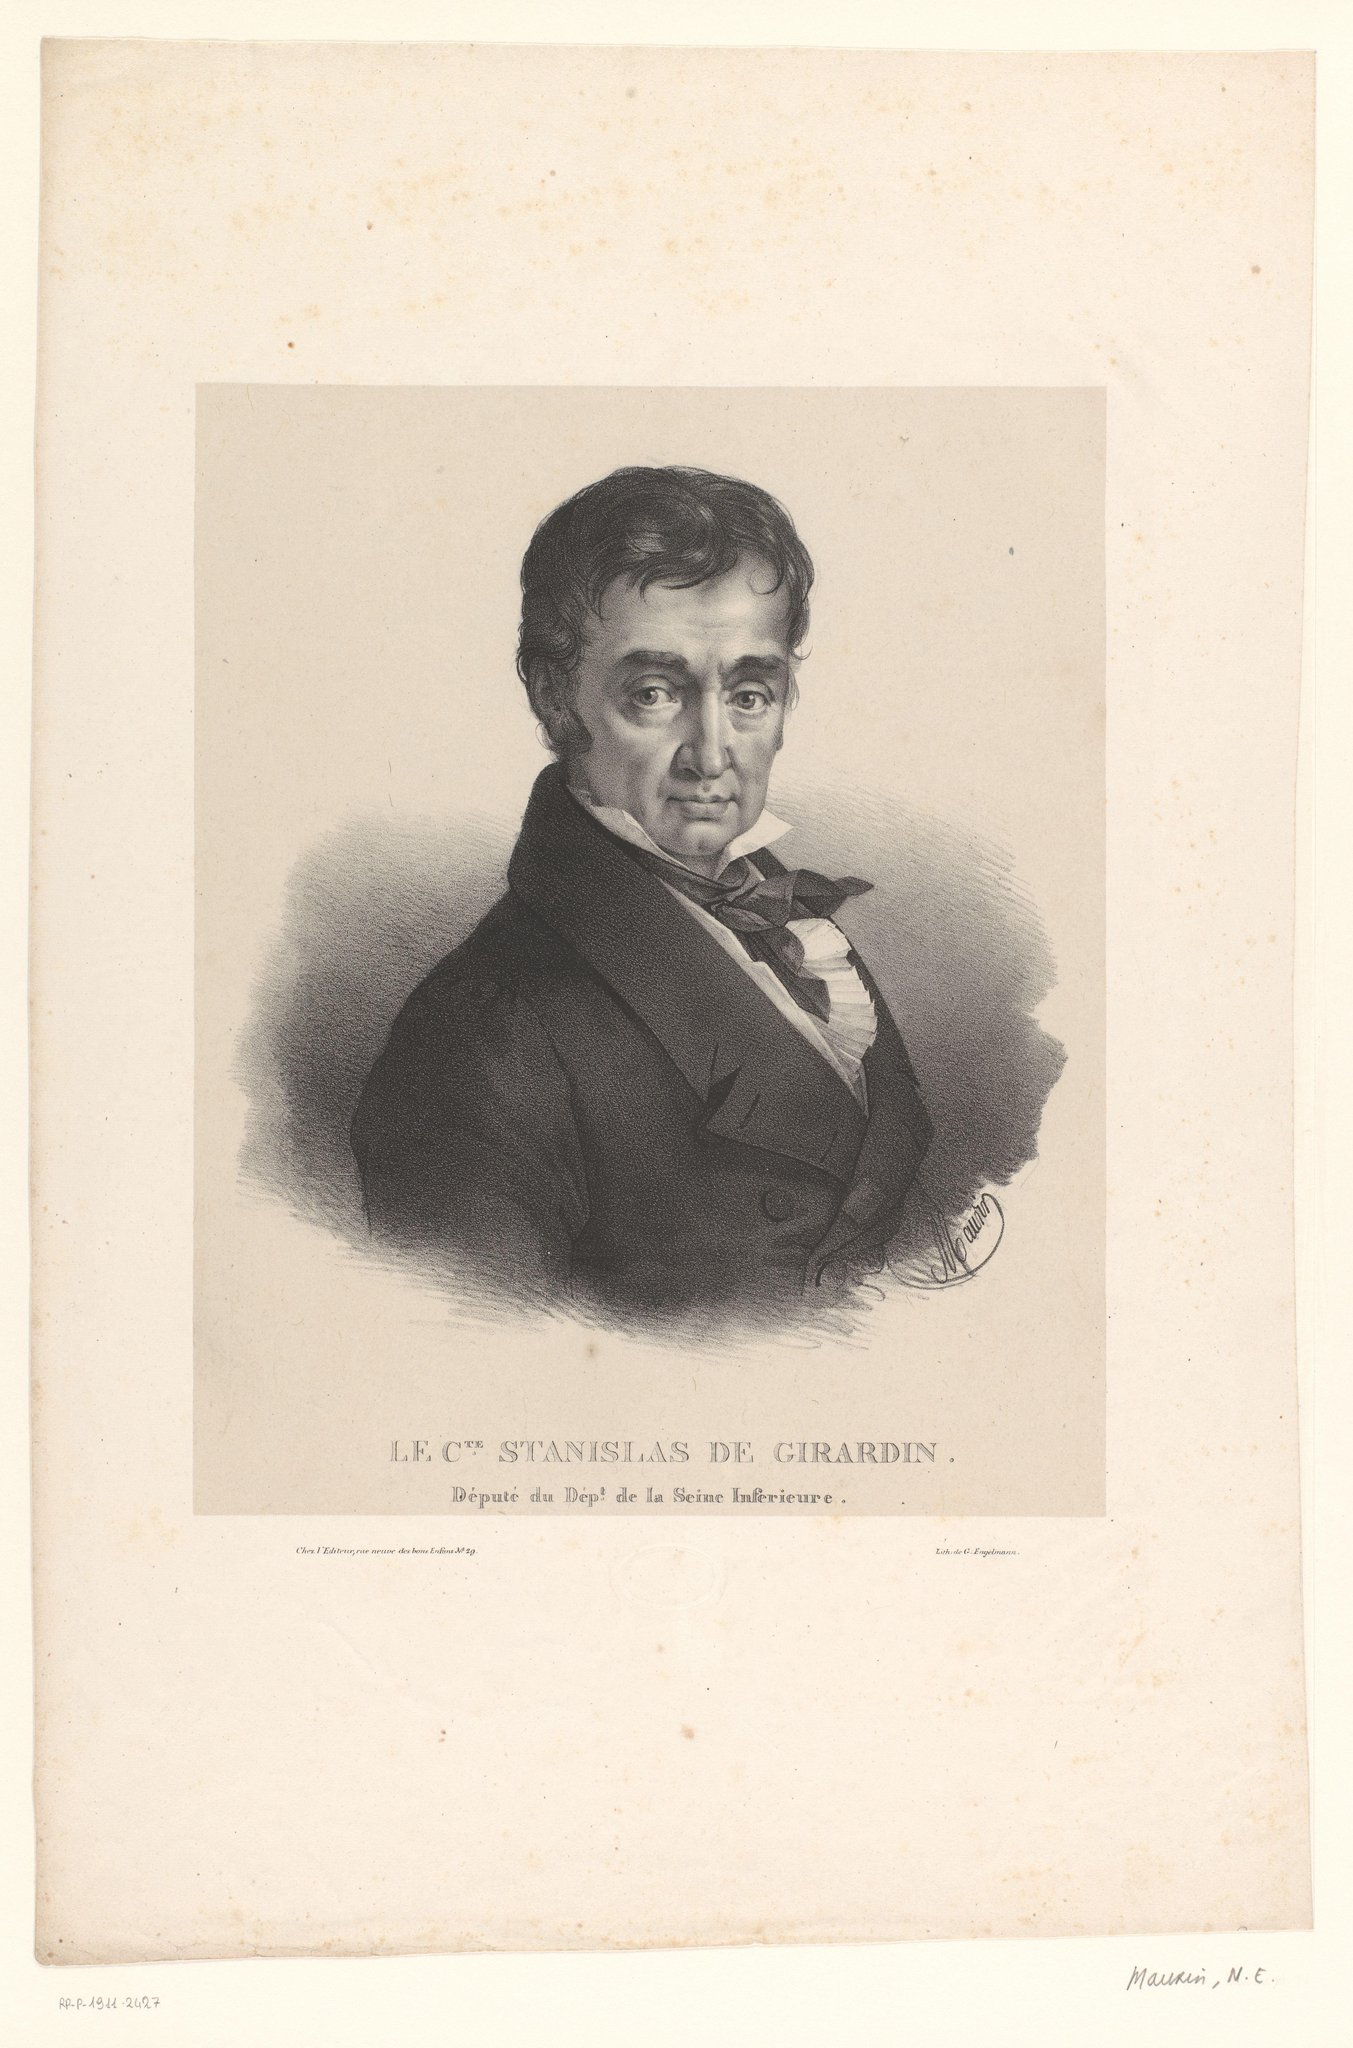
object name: print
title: Le cte. Stanislas de Girardin, député du dépt. de la Seine Inferieure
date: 1816-1839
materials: paper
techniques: lithograph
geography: paris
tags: paris, politician, historical persons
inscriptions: collector's mark: Lugt 2228, check stamp: